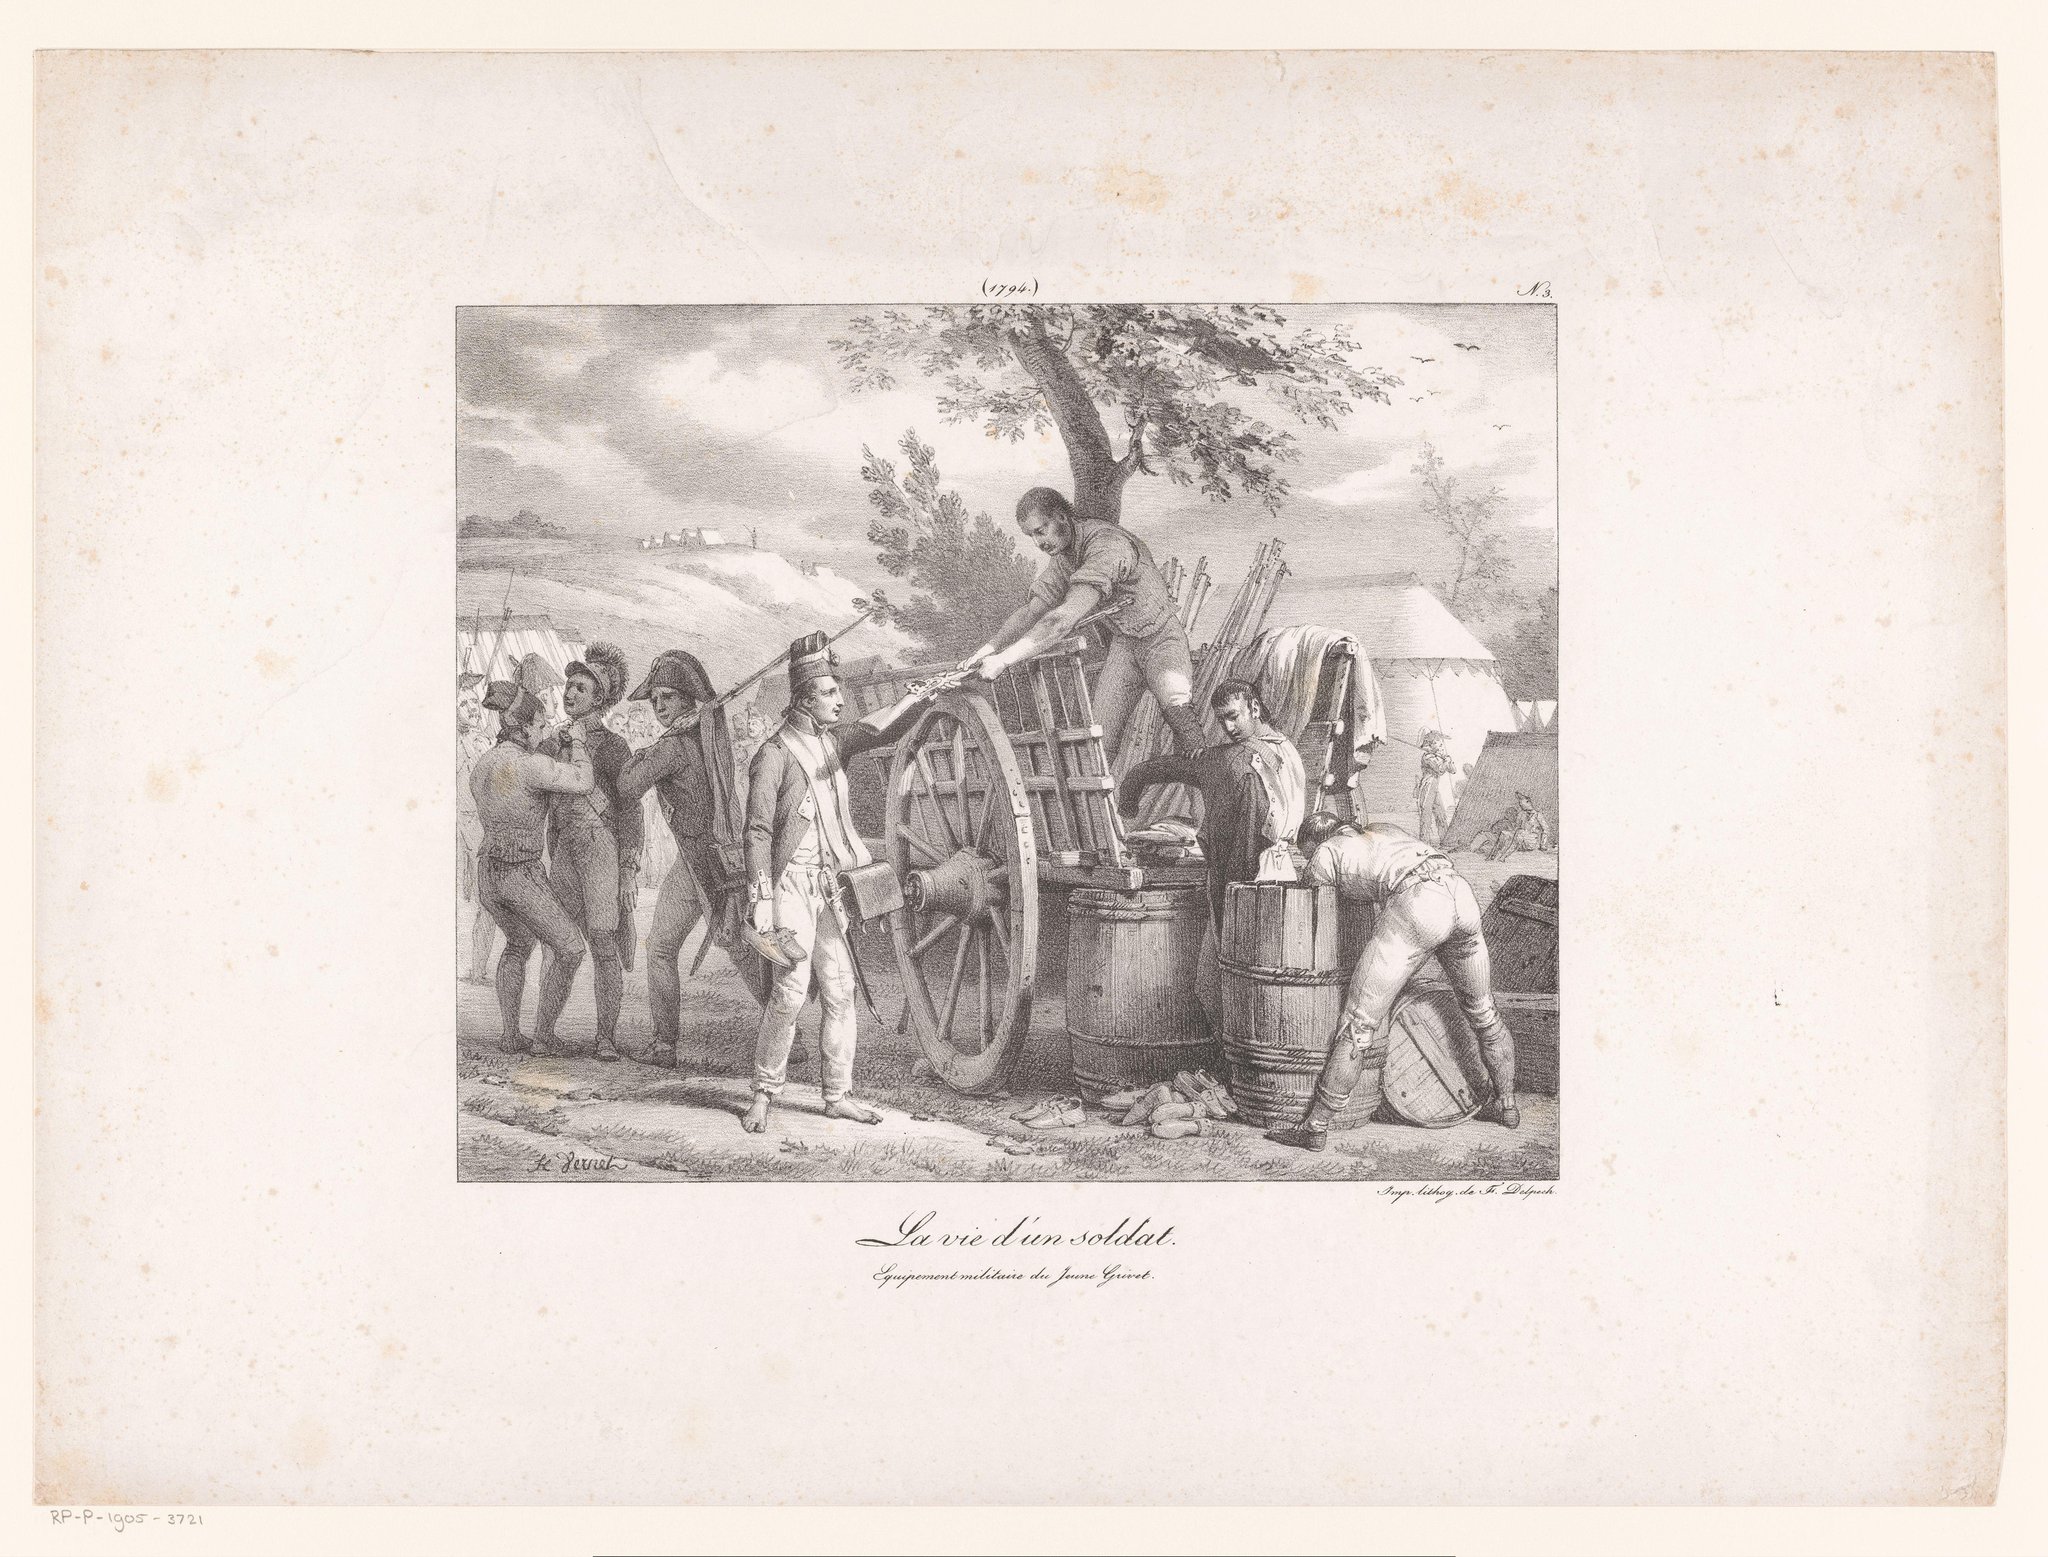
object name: print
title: Equipement militaire du jeune Grivet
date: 1818-1819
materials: paper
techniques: lithograph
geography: paris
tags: the soldier; the soldier's life, (military) equipment and supply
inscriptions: collector's mark: Lugt 2228